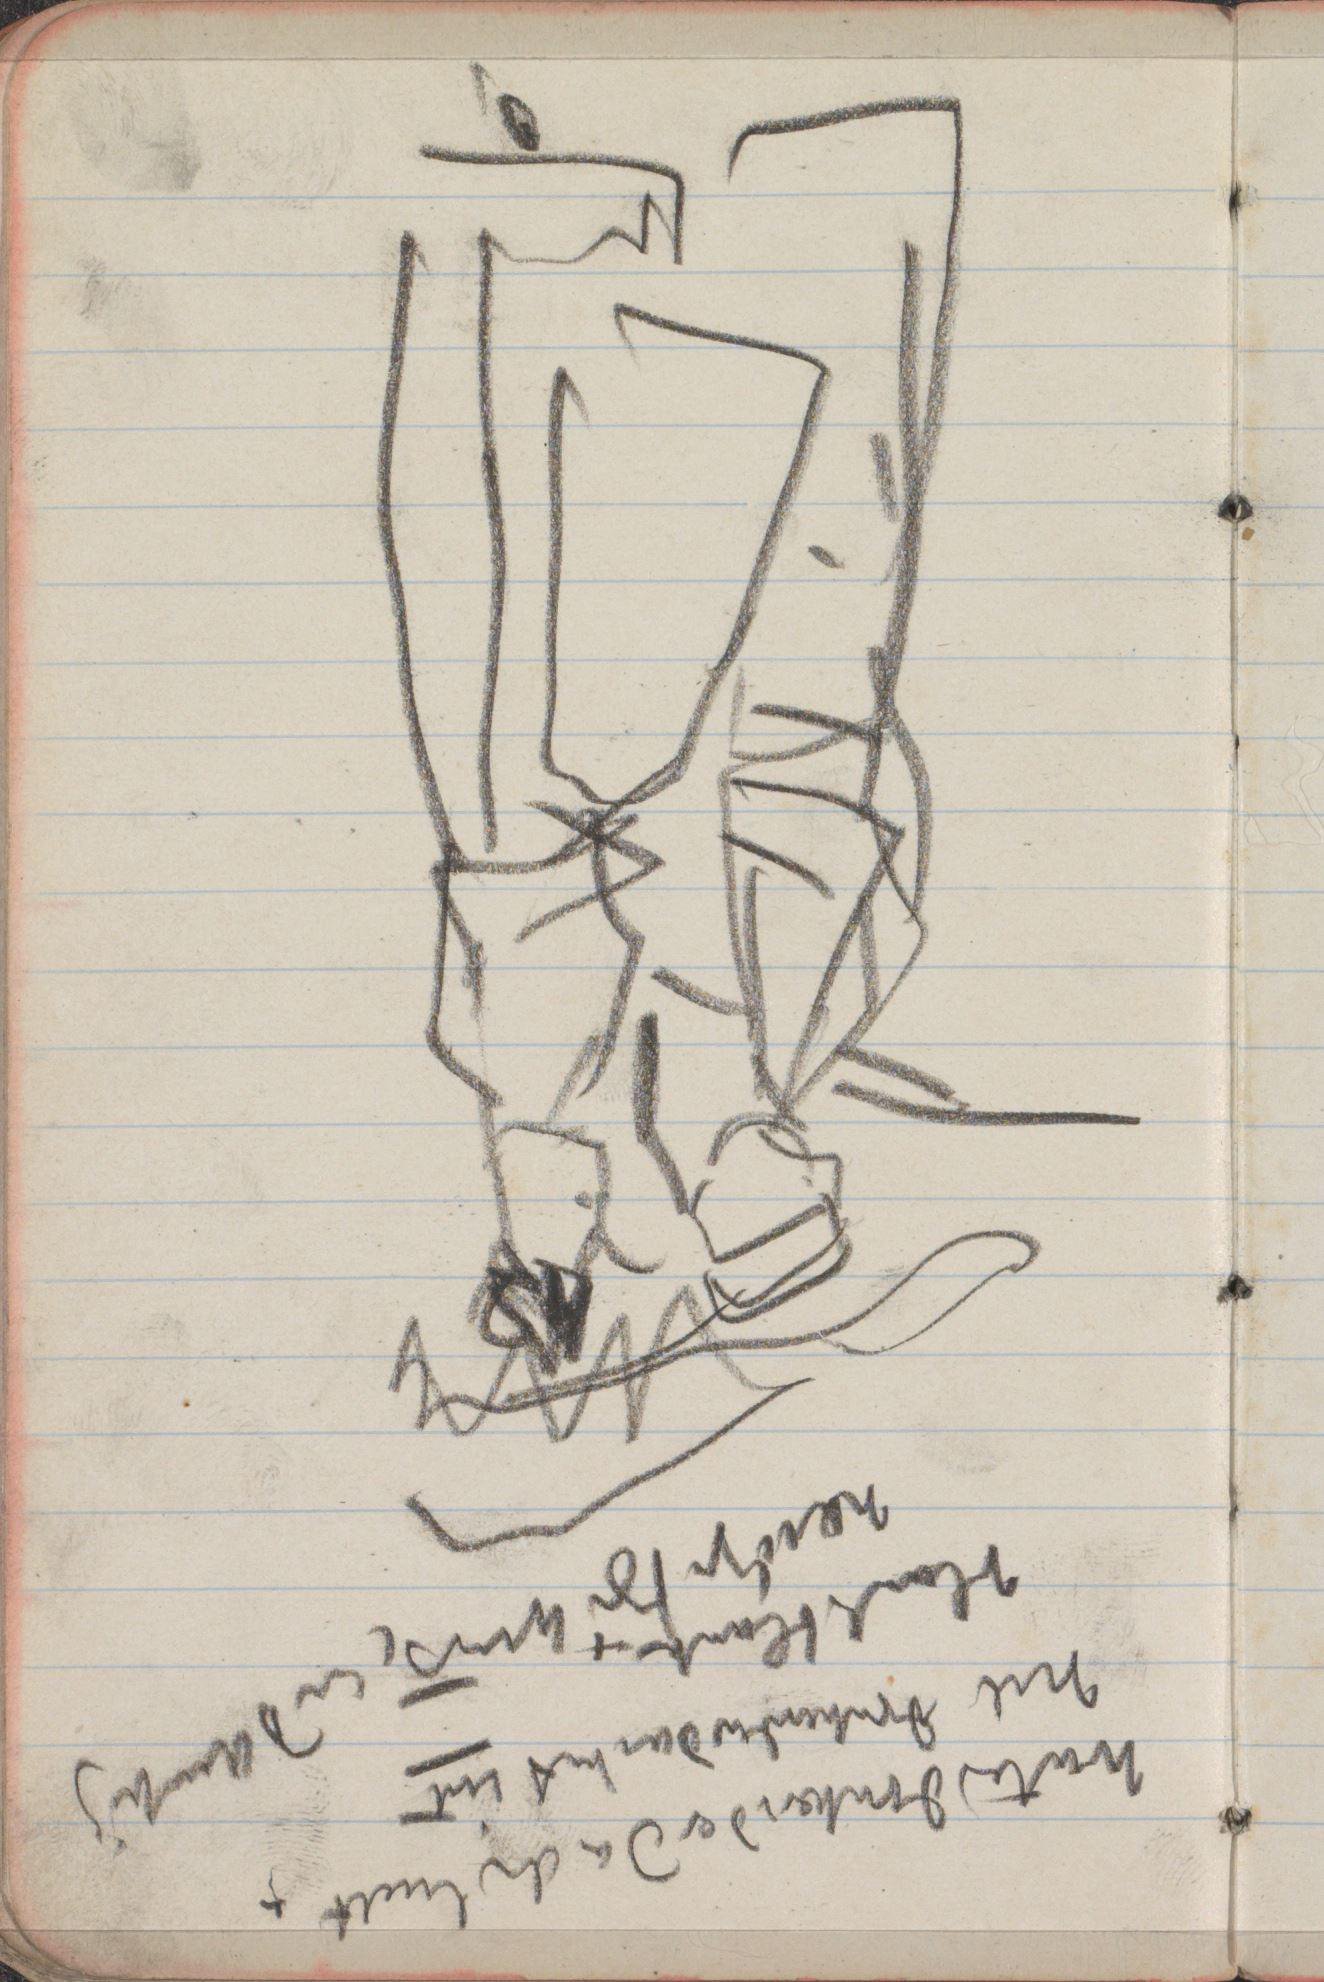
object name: sketchbook leaf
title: Twee vrouwen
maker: george hendrik breitner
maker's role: draughtsman, painter, print maker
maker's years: 1857-1923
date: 1892-1900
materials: chalk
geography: amsterdam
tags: adult woman (+ two persons)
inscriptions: kleurnotitie, handgeschreven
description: Pagina 37 uit een schetsboek met 38 bladen.